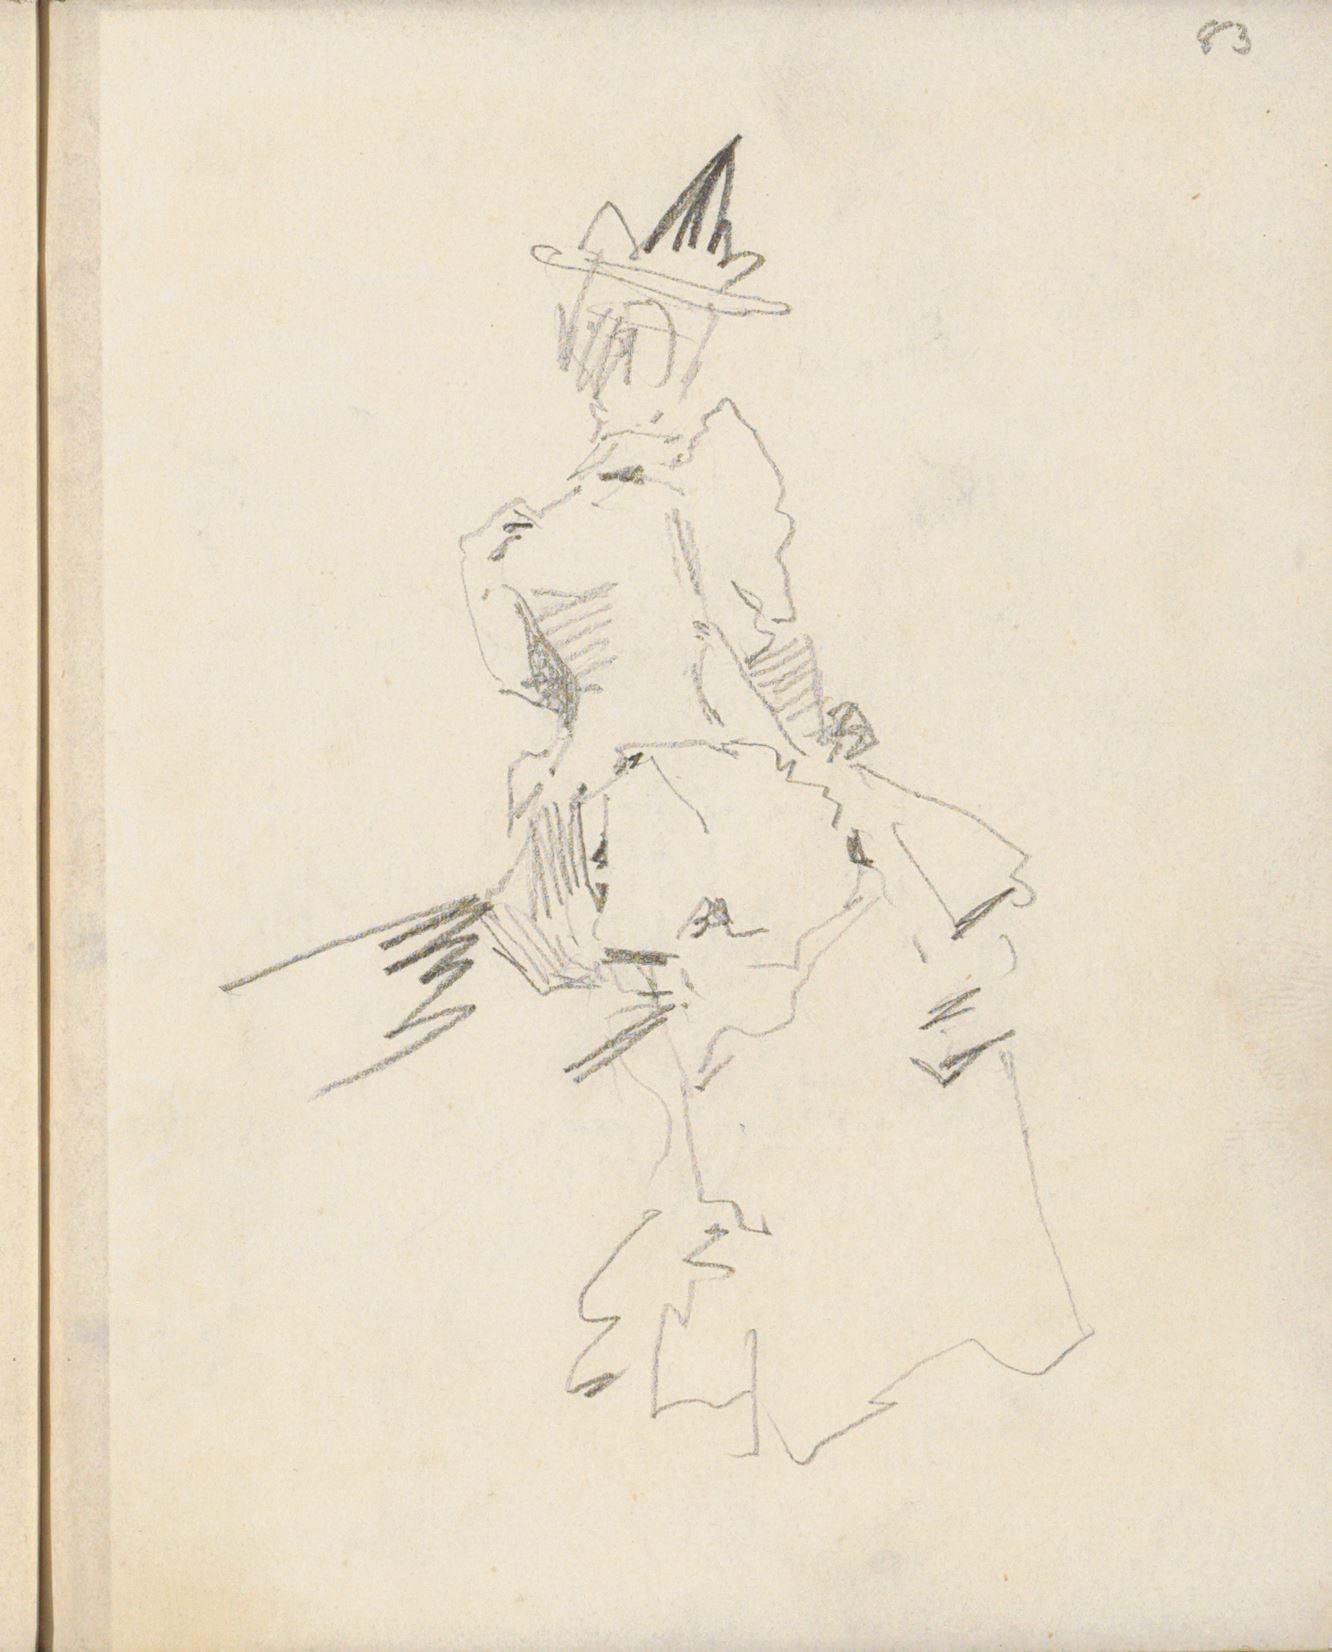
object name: sketchbook leaf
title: Zittende vrouw met een hoed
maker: alfred william rich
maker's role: draughtsman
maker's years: 1856-1921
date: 1892-1893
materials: paper, pencil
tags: sitting figure - aa - female human figure, head-gear: hat (+ women's clothes)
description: Blad 83 recto uit een schetsboek met 86 bladen.